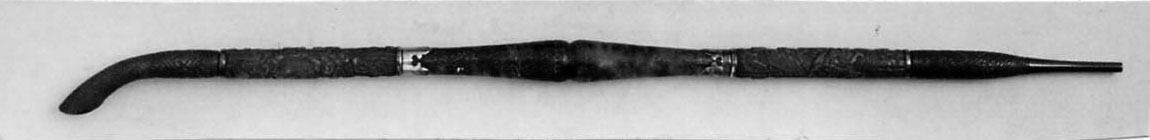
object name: tobacco pipe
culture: japanese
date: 1801-1900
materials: bronze, silver, wood